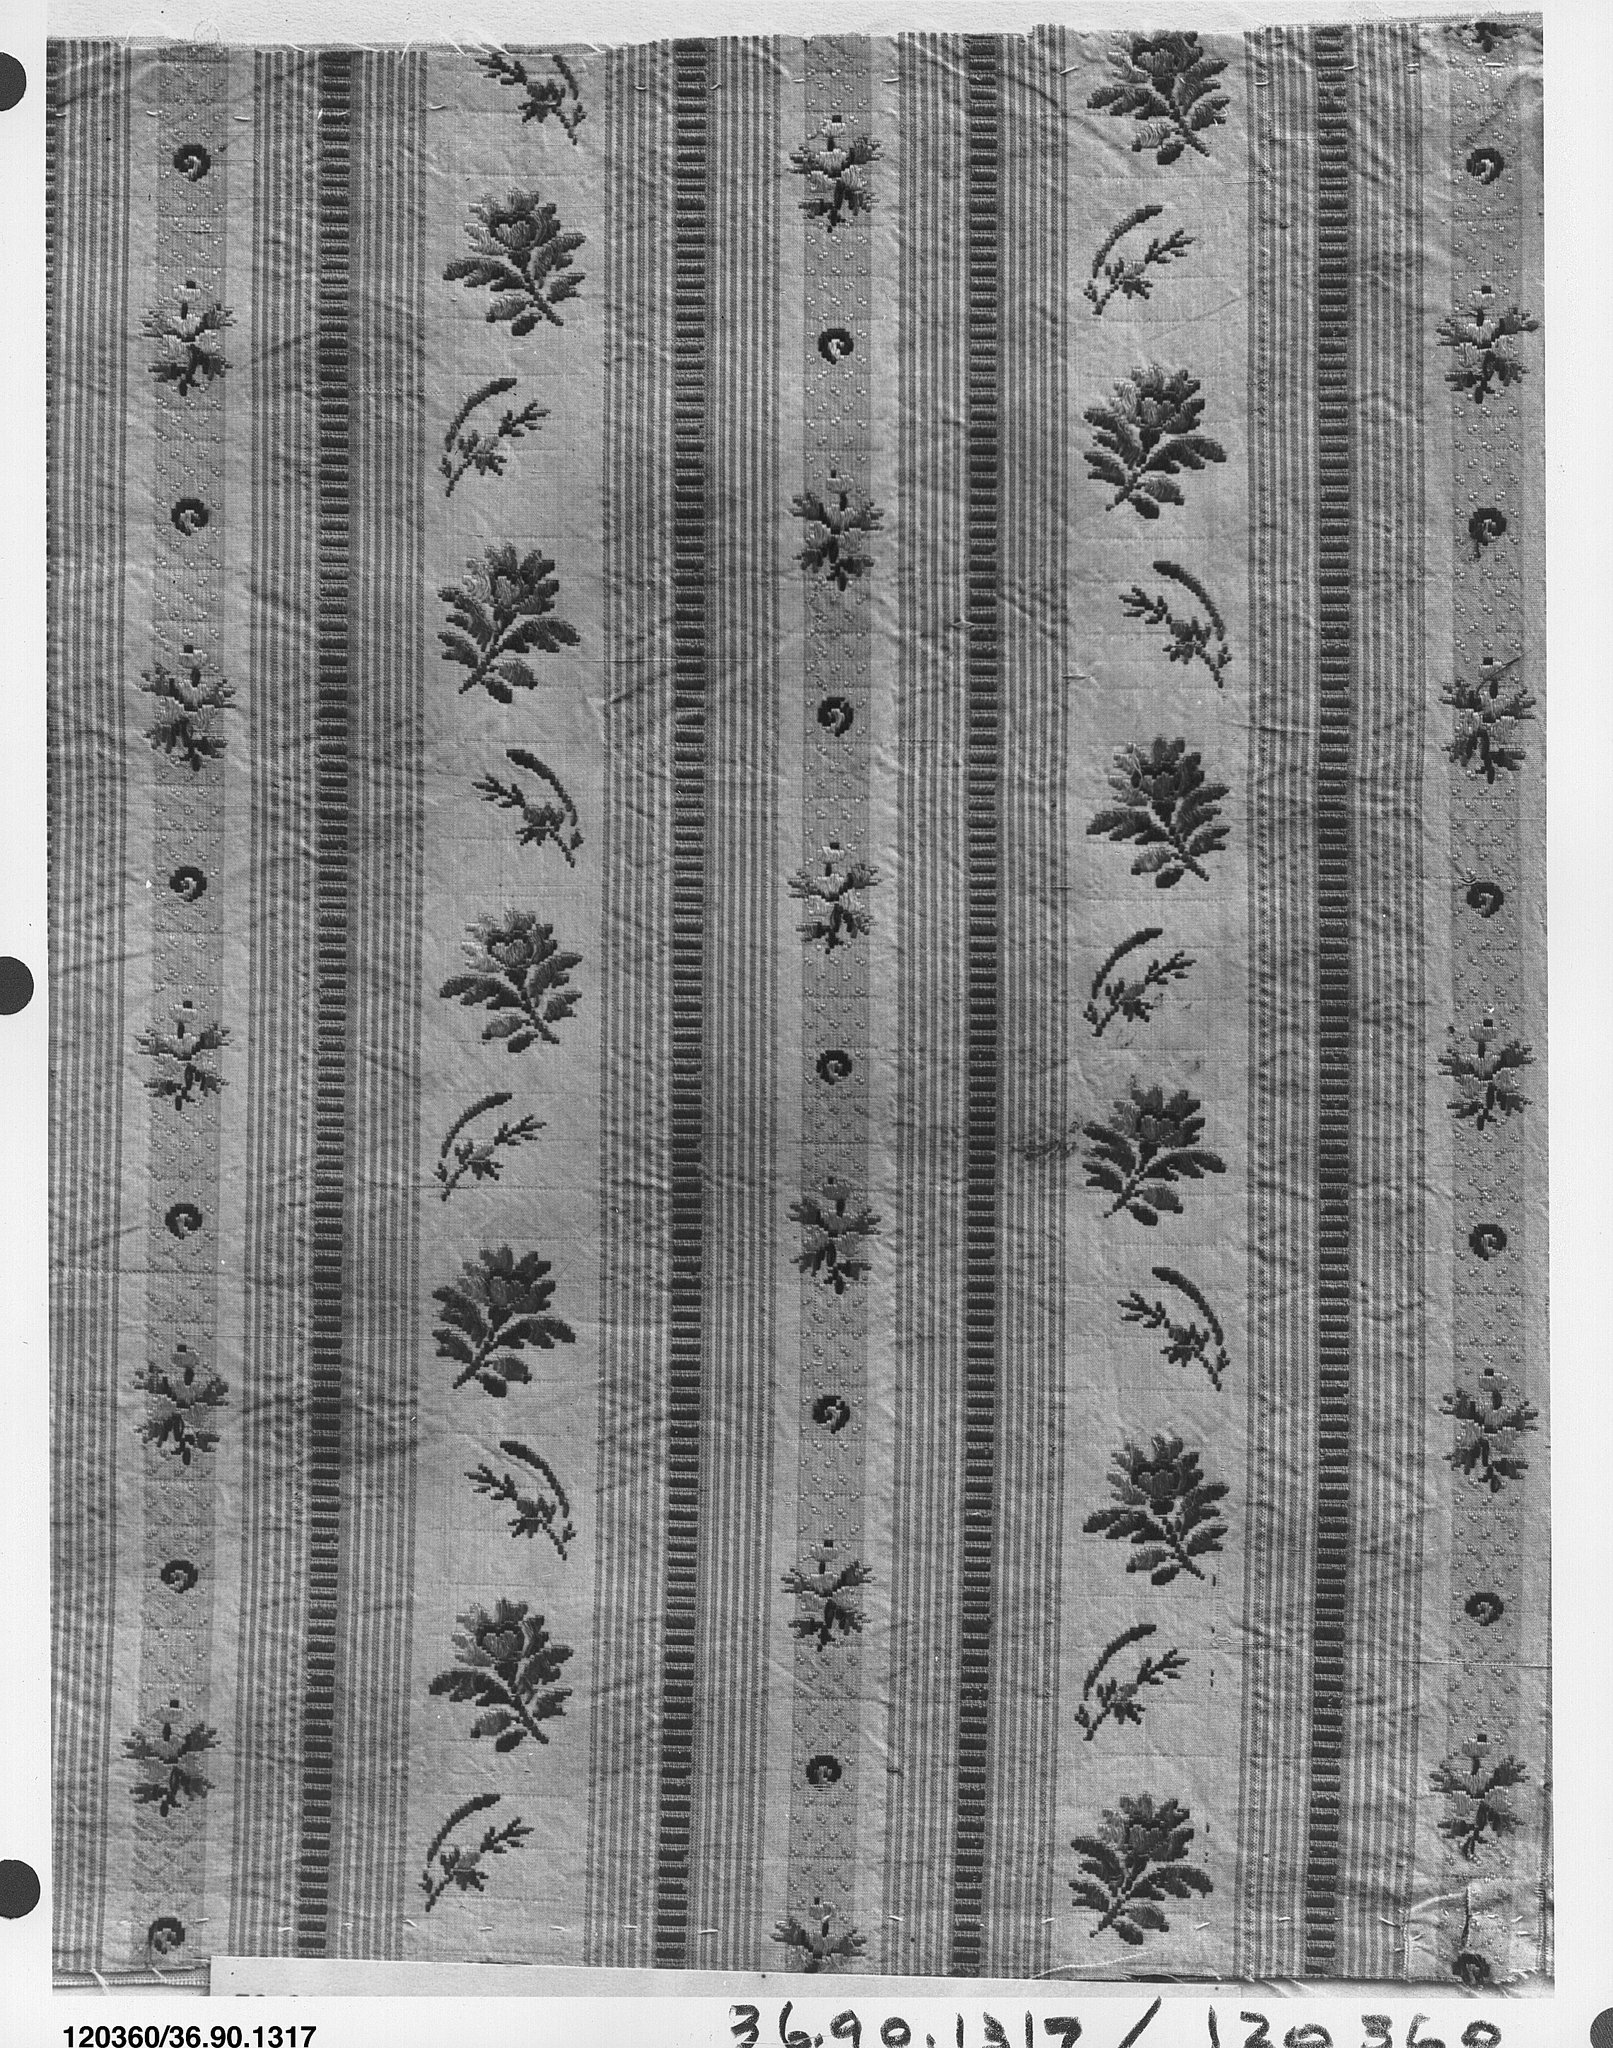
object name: piece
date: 1701-1800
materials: silk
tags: flowers,leaves